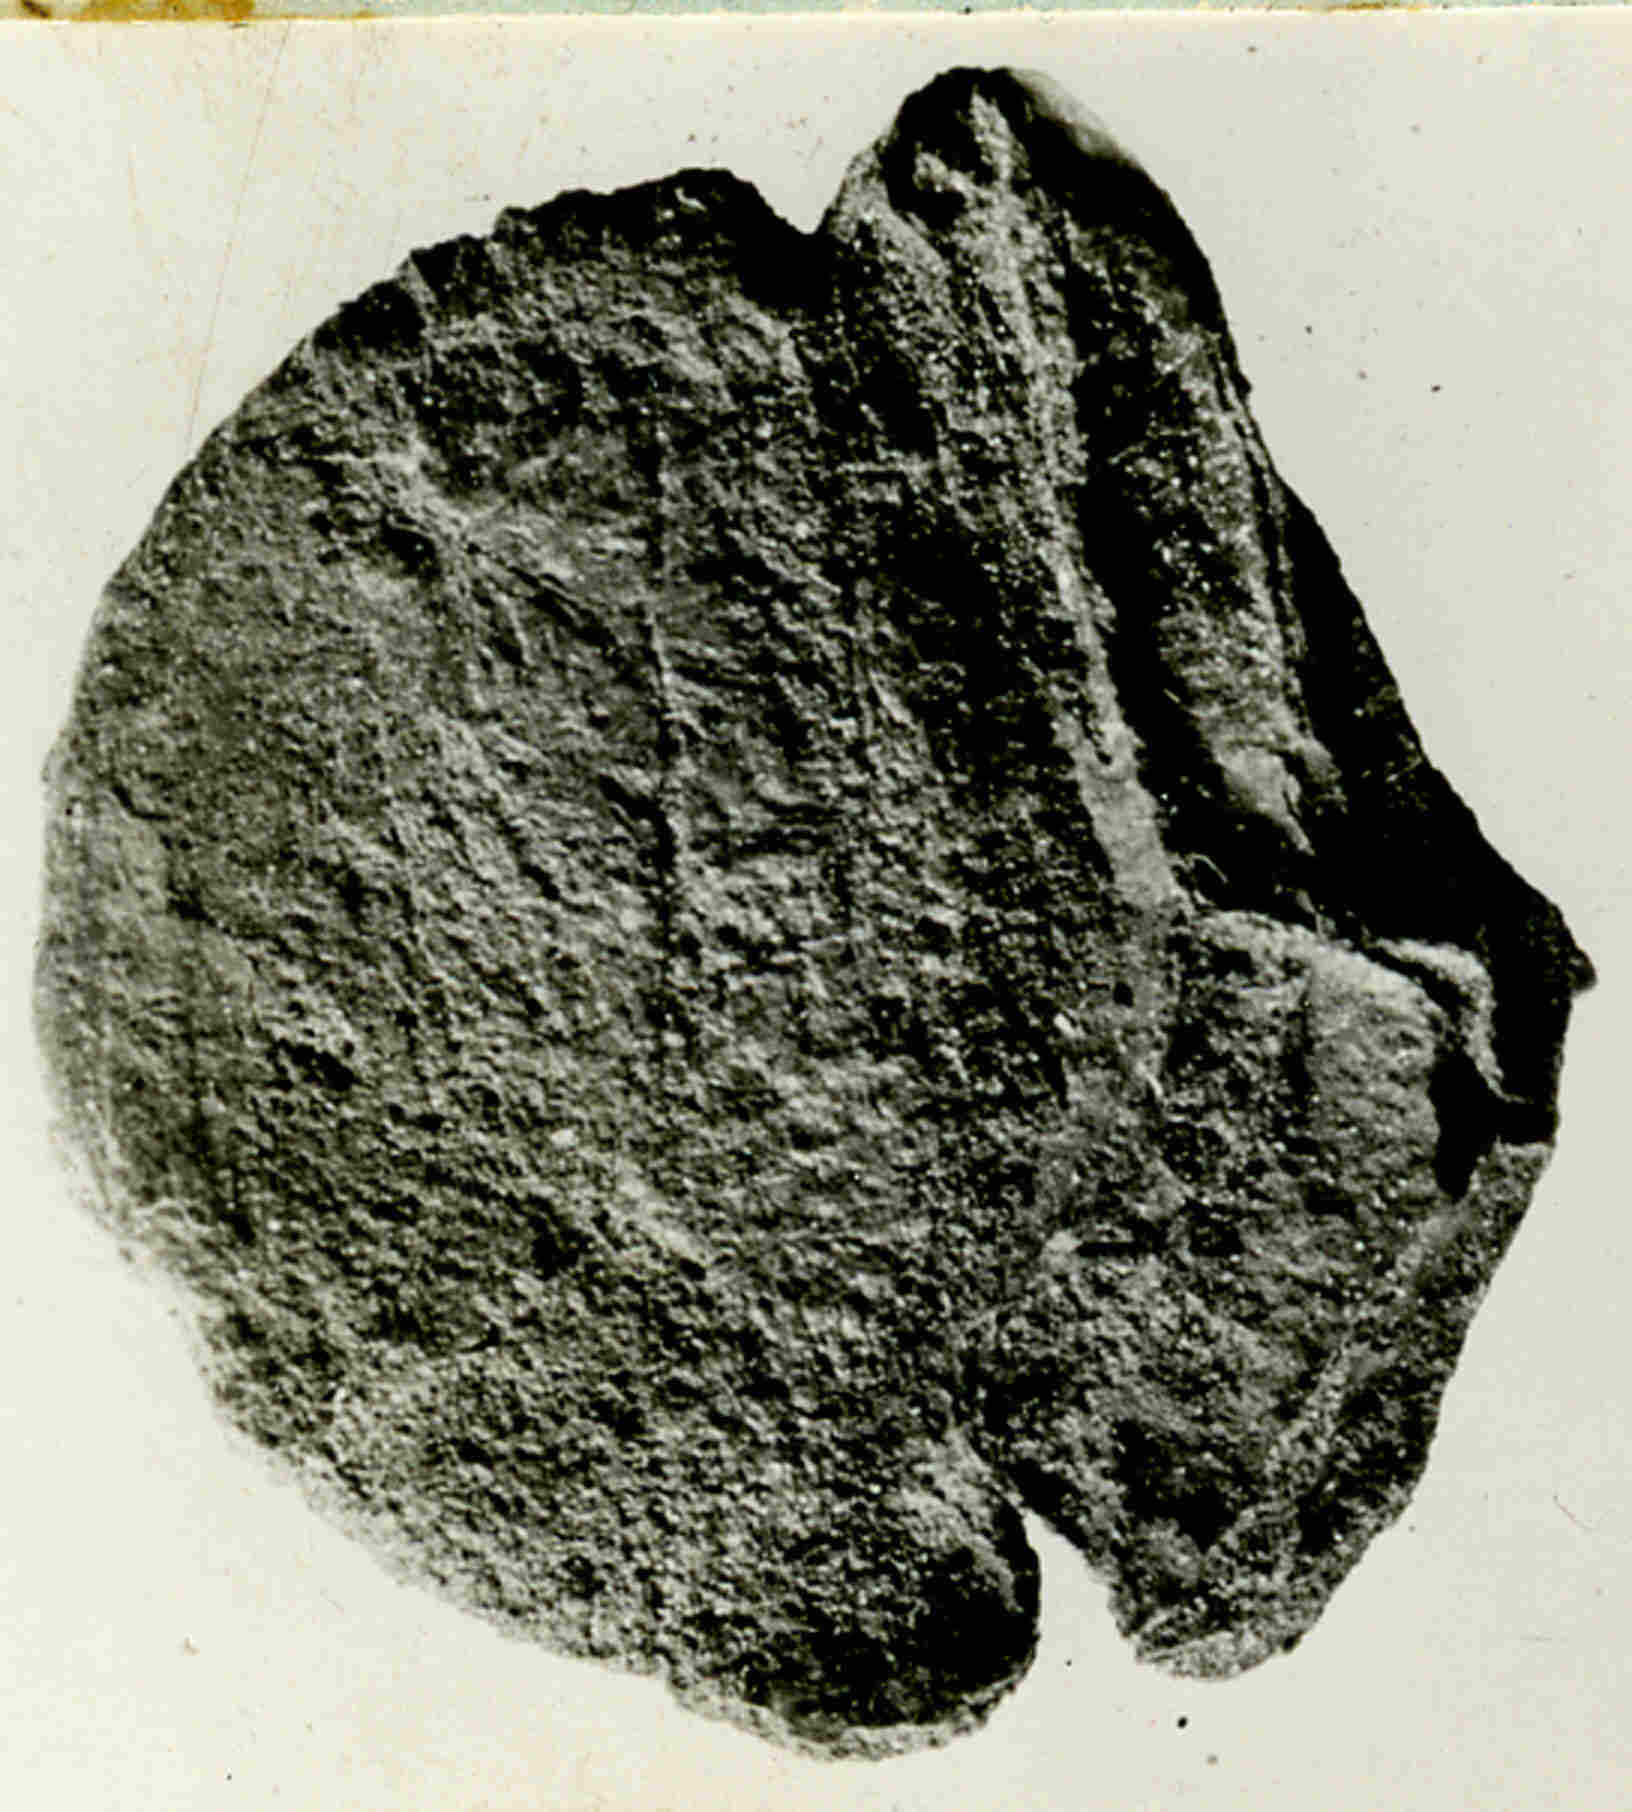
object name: coin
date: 701-900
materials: copper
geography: iran